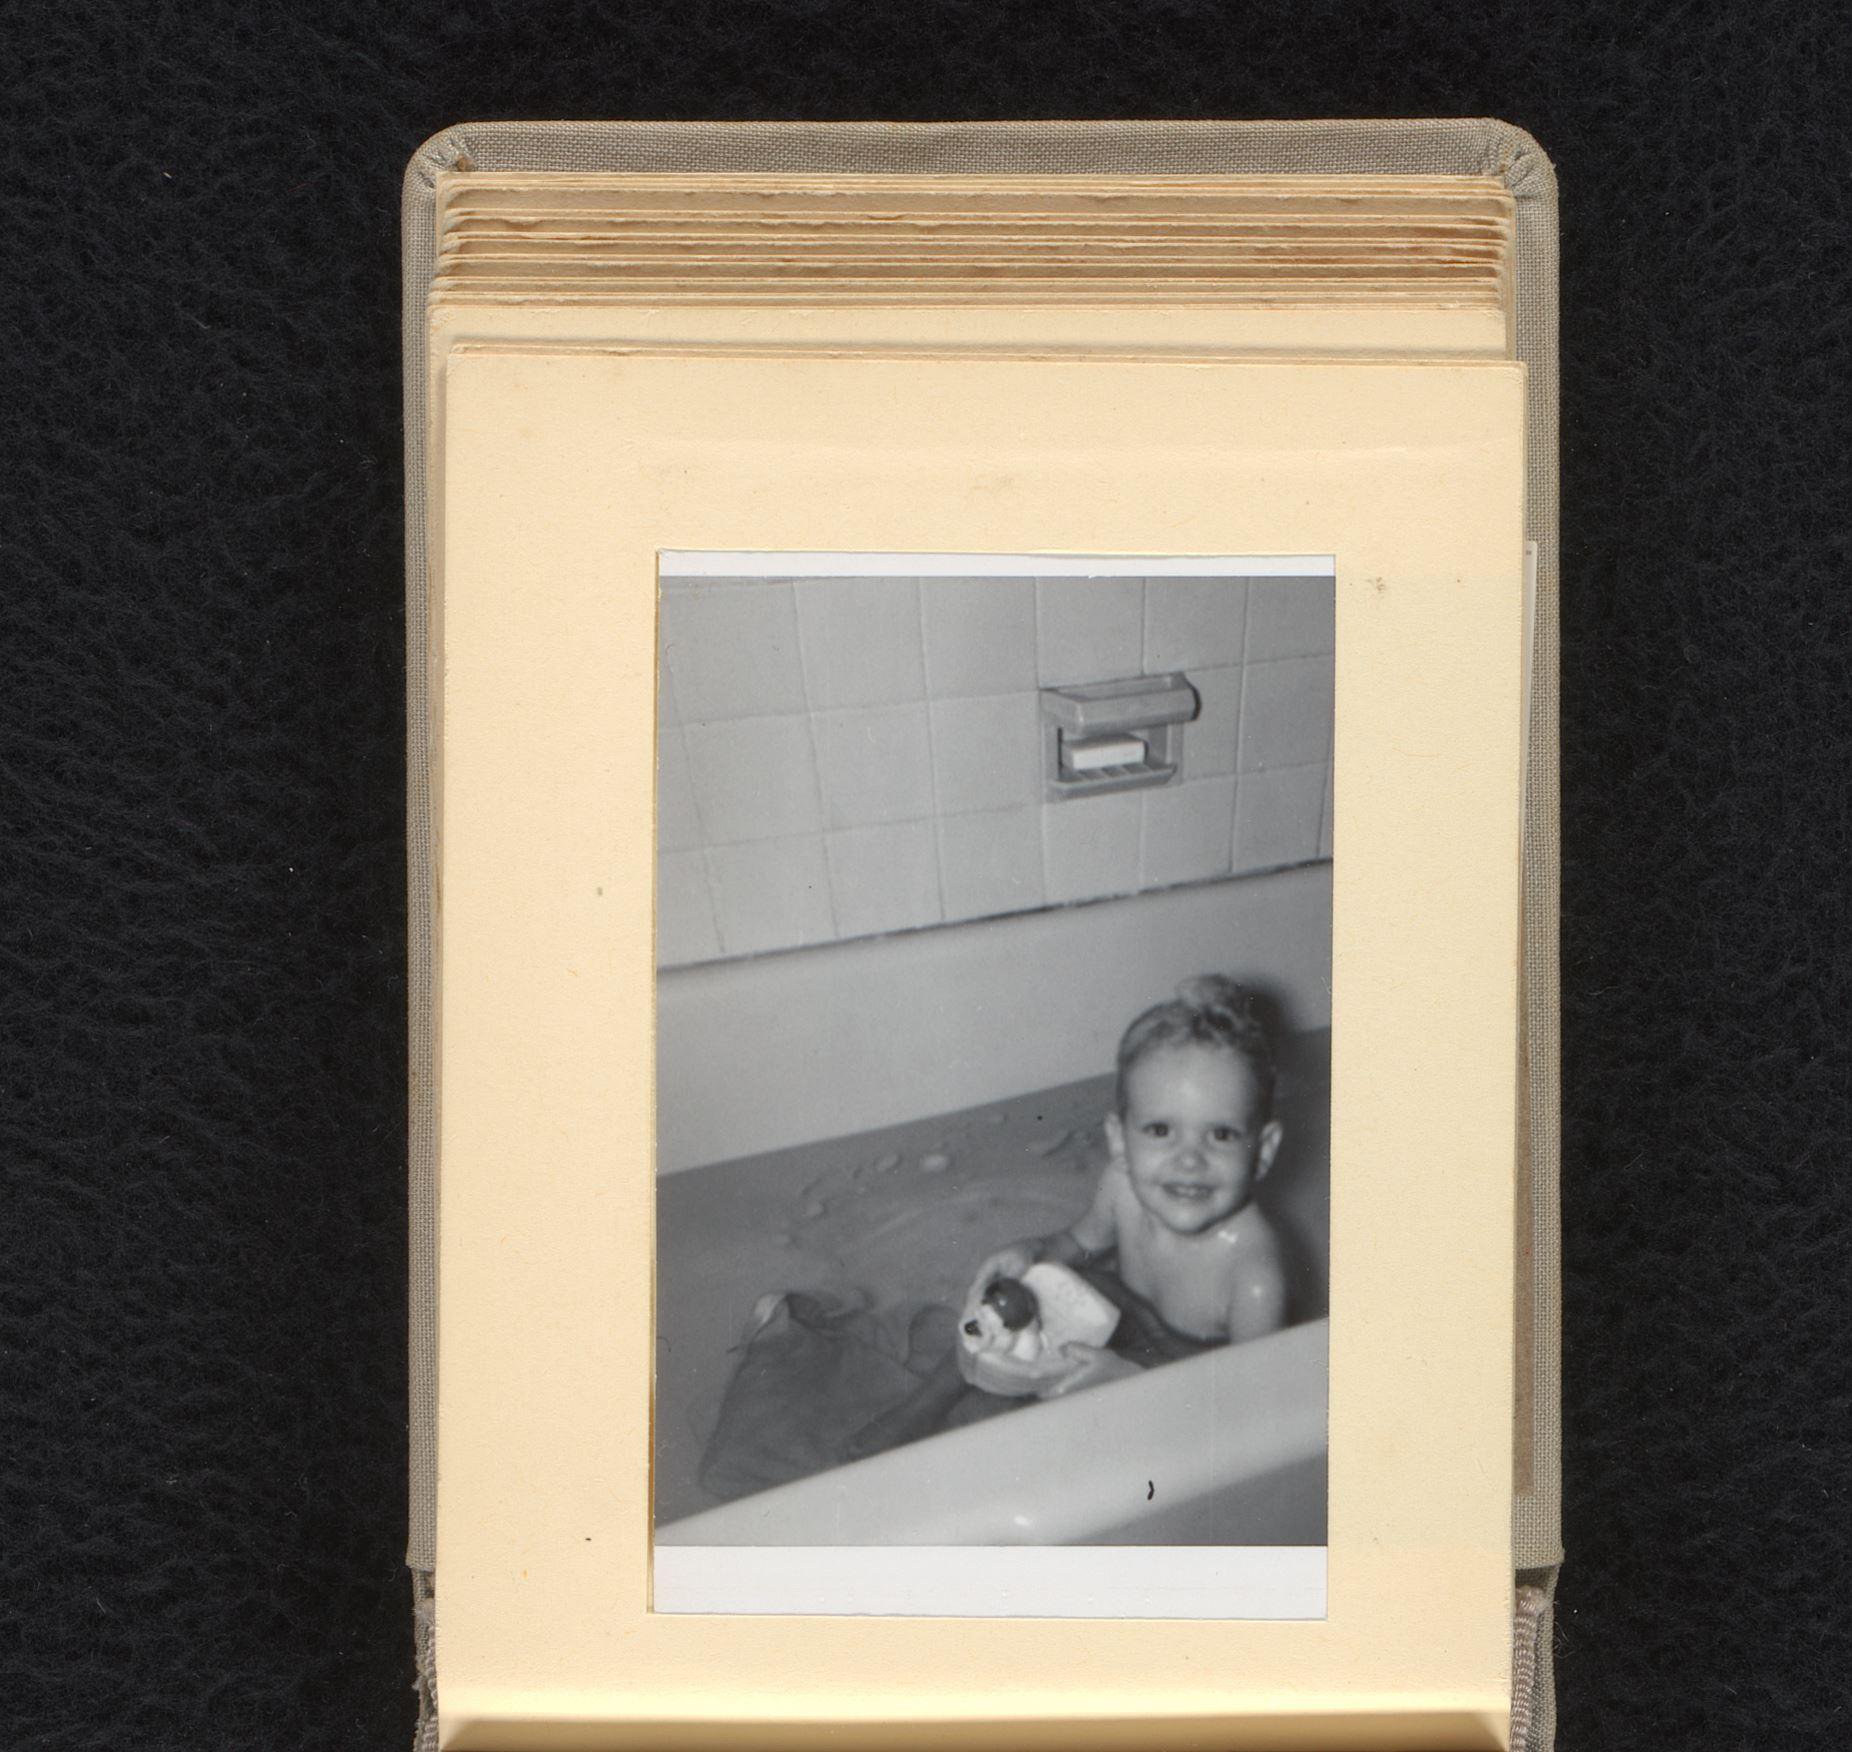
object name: photograph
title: Onbekend meisje in bad, november 1960, Verenigde Staten / Portret van Ursel, Basel 1946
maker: isabel wachenheimer-elon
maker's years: 1928-2010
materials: paper, photographic support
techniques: gelatin silver print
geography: united states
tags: historical persons - bb - woman, bathing baby, united states of america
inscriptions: inscription: ‘Mit viel viel Liebe ... Ursel / Basel 29 Sept. 1946’, date: ‘Nov 1960’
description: Albumblad bevat met twee foto's van onbekend meisje in bad en een pasfoto van een vriendin Ursel in Basel, met briefje 29 september 1946. Onderdeel van het fotoalbum met diverse foto's van de jeugd van Isabel Wachenheimer voor en tijdens de oorlog en diverse momenten van haar volwassen leven na de Tweede Wereldoorlog.